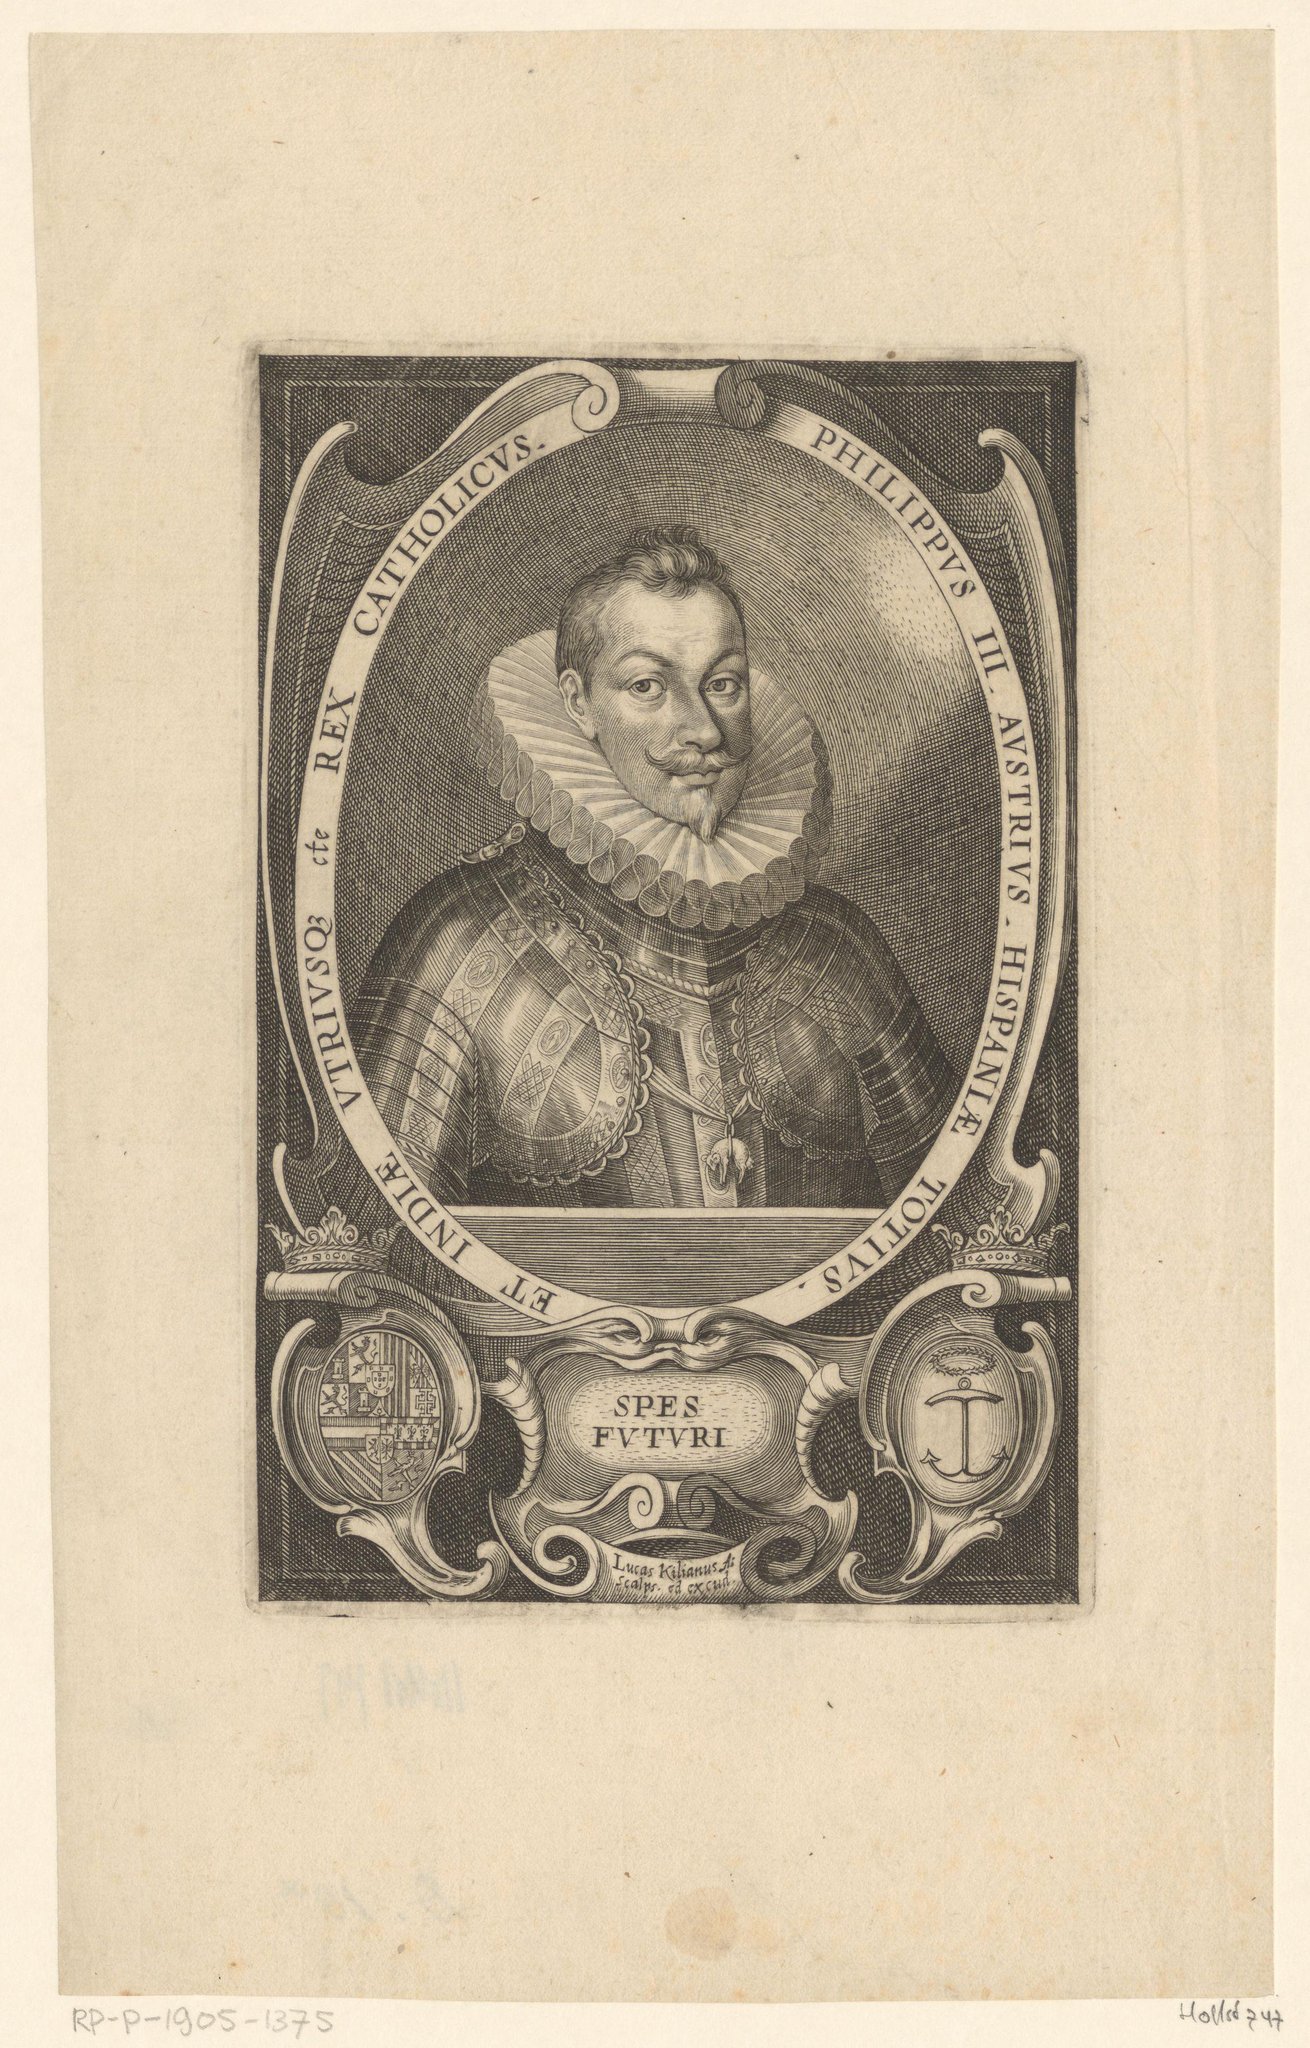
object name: print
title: Portret van Filips III, koning van Napels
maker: lucas kilian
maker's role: draughtsman, print maker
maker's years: 1579-1637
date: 1589-1624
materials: paper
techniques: engraving, etching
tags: filips iii (koning van spanje), historical persons, knighthood order of the golden fleece - insignia of a knighthood order, e.g.: badge, chain (with name of order), king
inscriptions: collector's mark: Lugt 2228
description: Deze prent is gebruikt in: Mazzella, Scipione, Kilian, Lucas en Custos, Dominicus. Der Neapolitanische Koenige Leben und Bildnisse (...). Augsburg: Lucas Kilian, 1624.